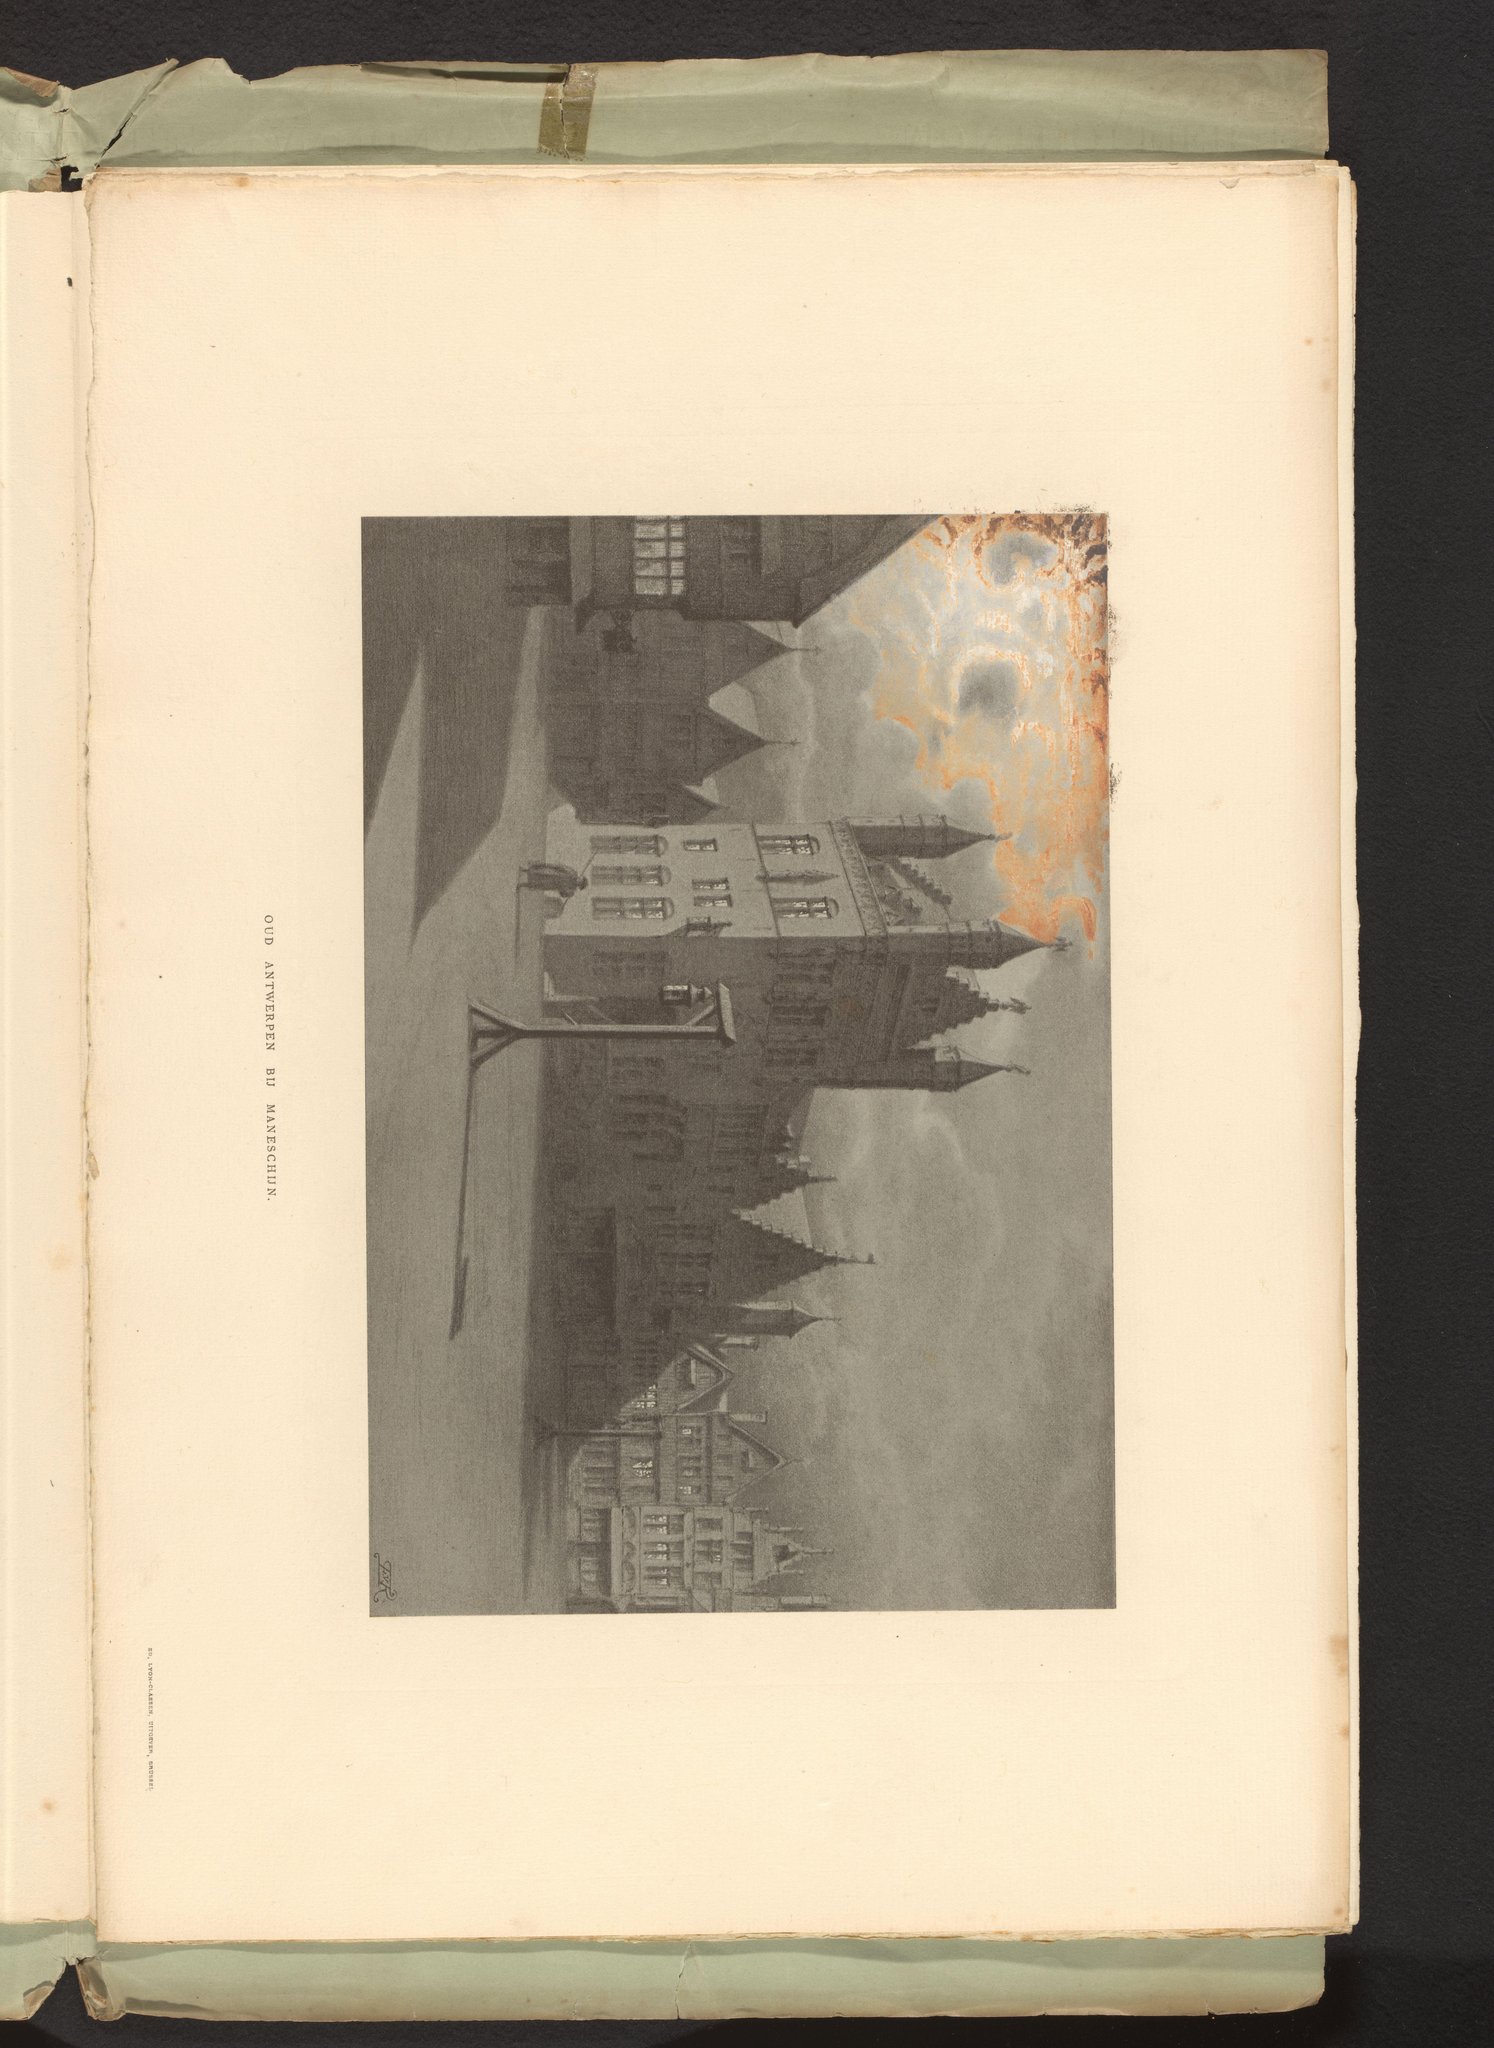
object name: page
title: Reproductie van een aquarel van Oud-Antwerpen op de Wereldtentoonstelling van 1894 in Antwerpen, door Frans van Kuyk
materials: paper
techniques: autotype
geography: antwerp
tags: world fair, world exhibition, antwerp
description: Prent op los blad tussen pagina 10 en 11.